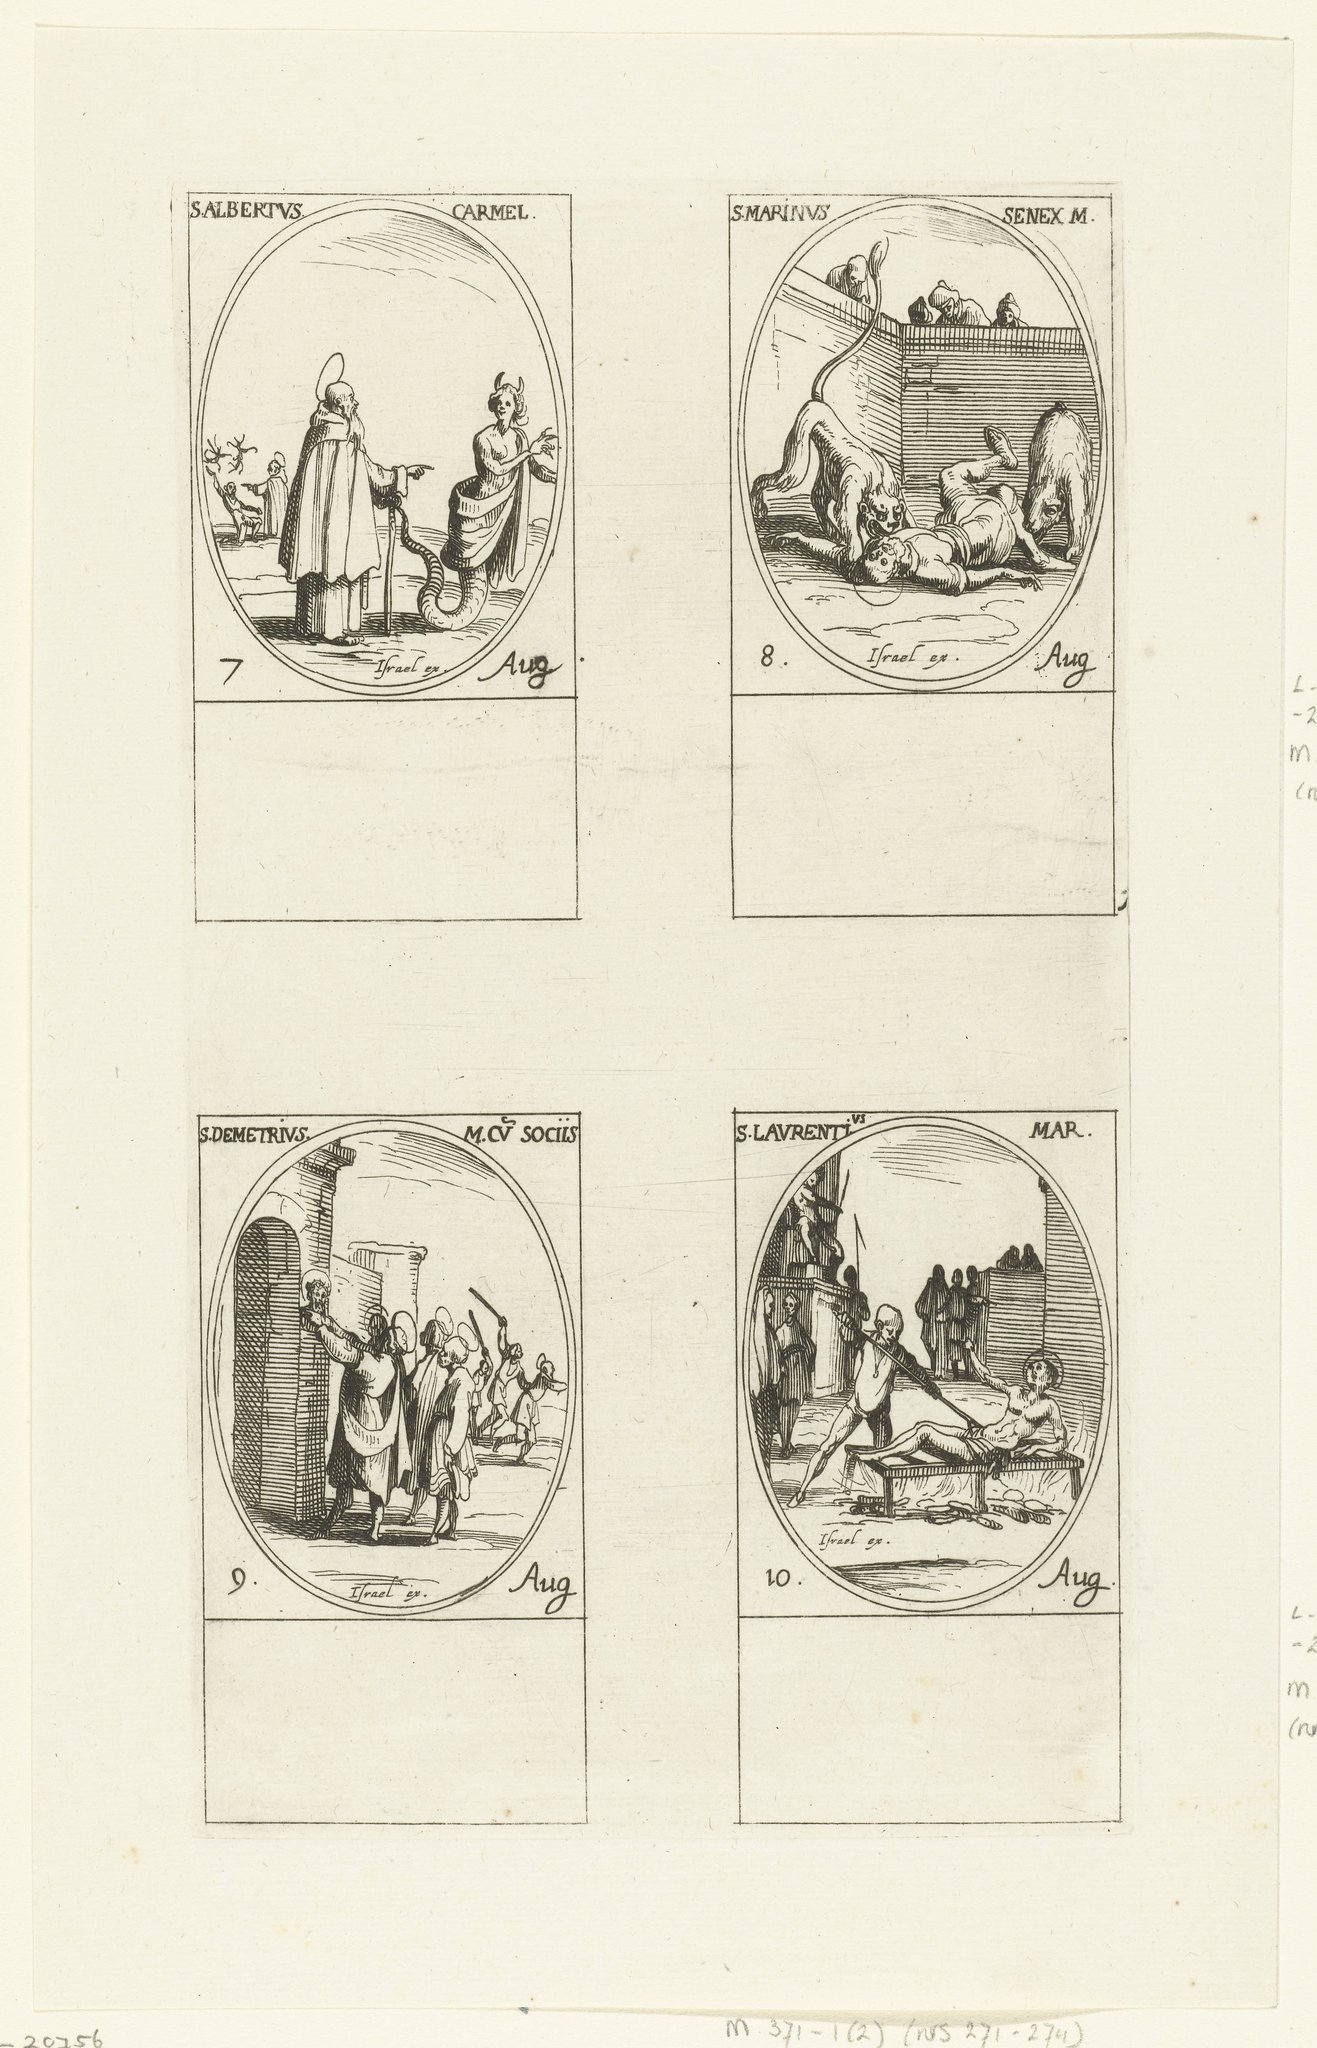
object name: print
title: Alle heiligen en de Christelijke feestdagen van het jaar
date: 1632-1636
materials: paper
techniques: etching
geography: paris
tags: st. laurence is roasted on a gridiron, male saints (with name)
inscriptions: collector's mark: Lugt 240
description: Blad met vier ovale voorstellingen, elk met opschrift en datum in het Latijn: linksboven de Heilige Albertus van Trapani die een duivels wezen verjaagt, rechtsboven de Heilige Marinus van Anazarbus die door wilde dieren wordt verslonden, linksonder de Heilige Demetrius en gezellen bij een portret van Christus, rechtsonder de Heilige Laurentius die geroosterd wordt. Deze prent is onderdeel van een serie prenten met voorstellingen van de heiligen en de christelijke feestdagen van het jaar. Er zijn steeds vier scènes van één plaat op één blad gedrukt. Inclusief bijbehorend titelblad en frontispice gaat het in totaal om 124 platen (490 voorstellingen). De drie platen met de laatste 12 scènes (de veranderlijke christelijke feestdagen) zijn in de derde staat versneden tot 12 kleine plaatjes, en met een apart titelblad uitgegeven.